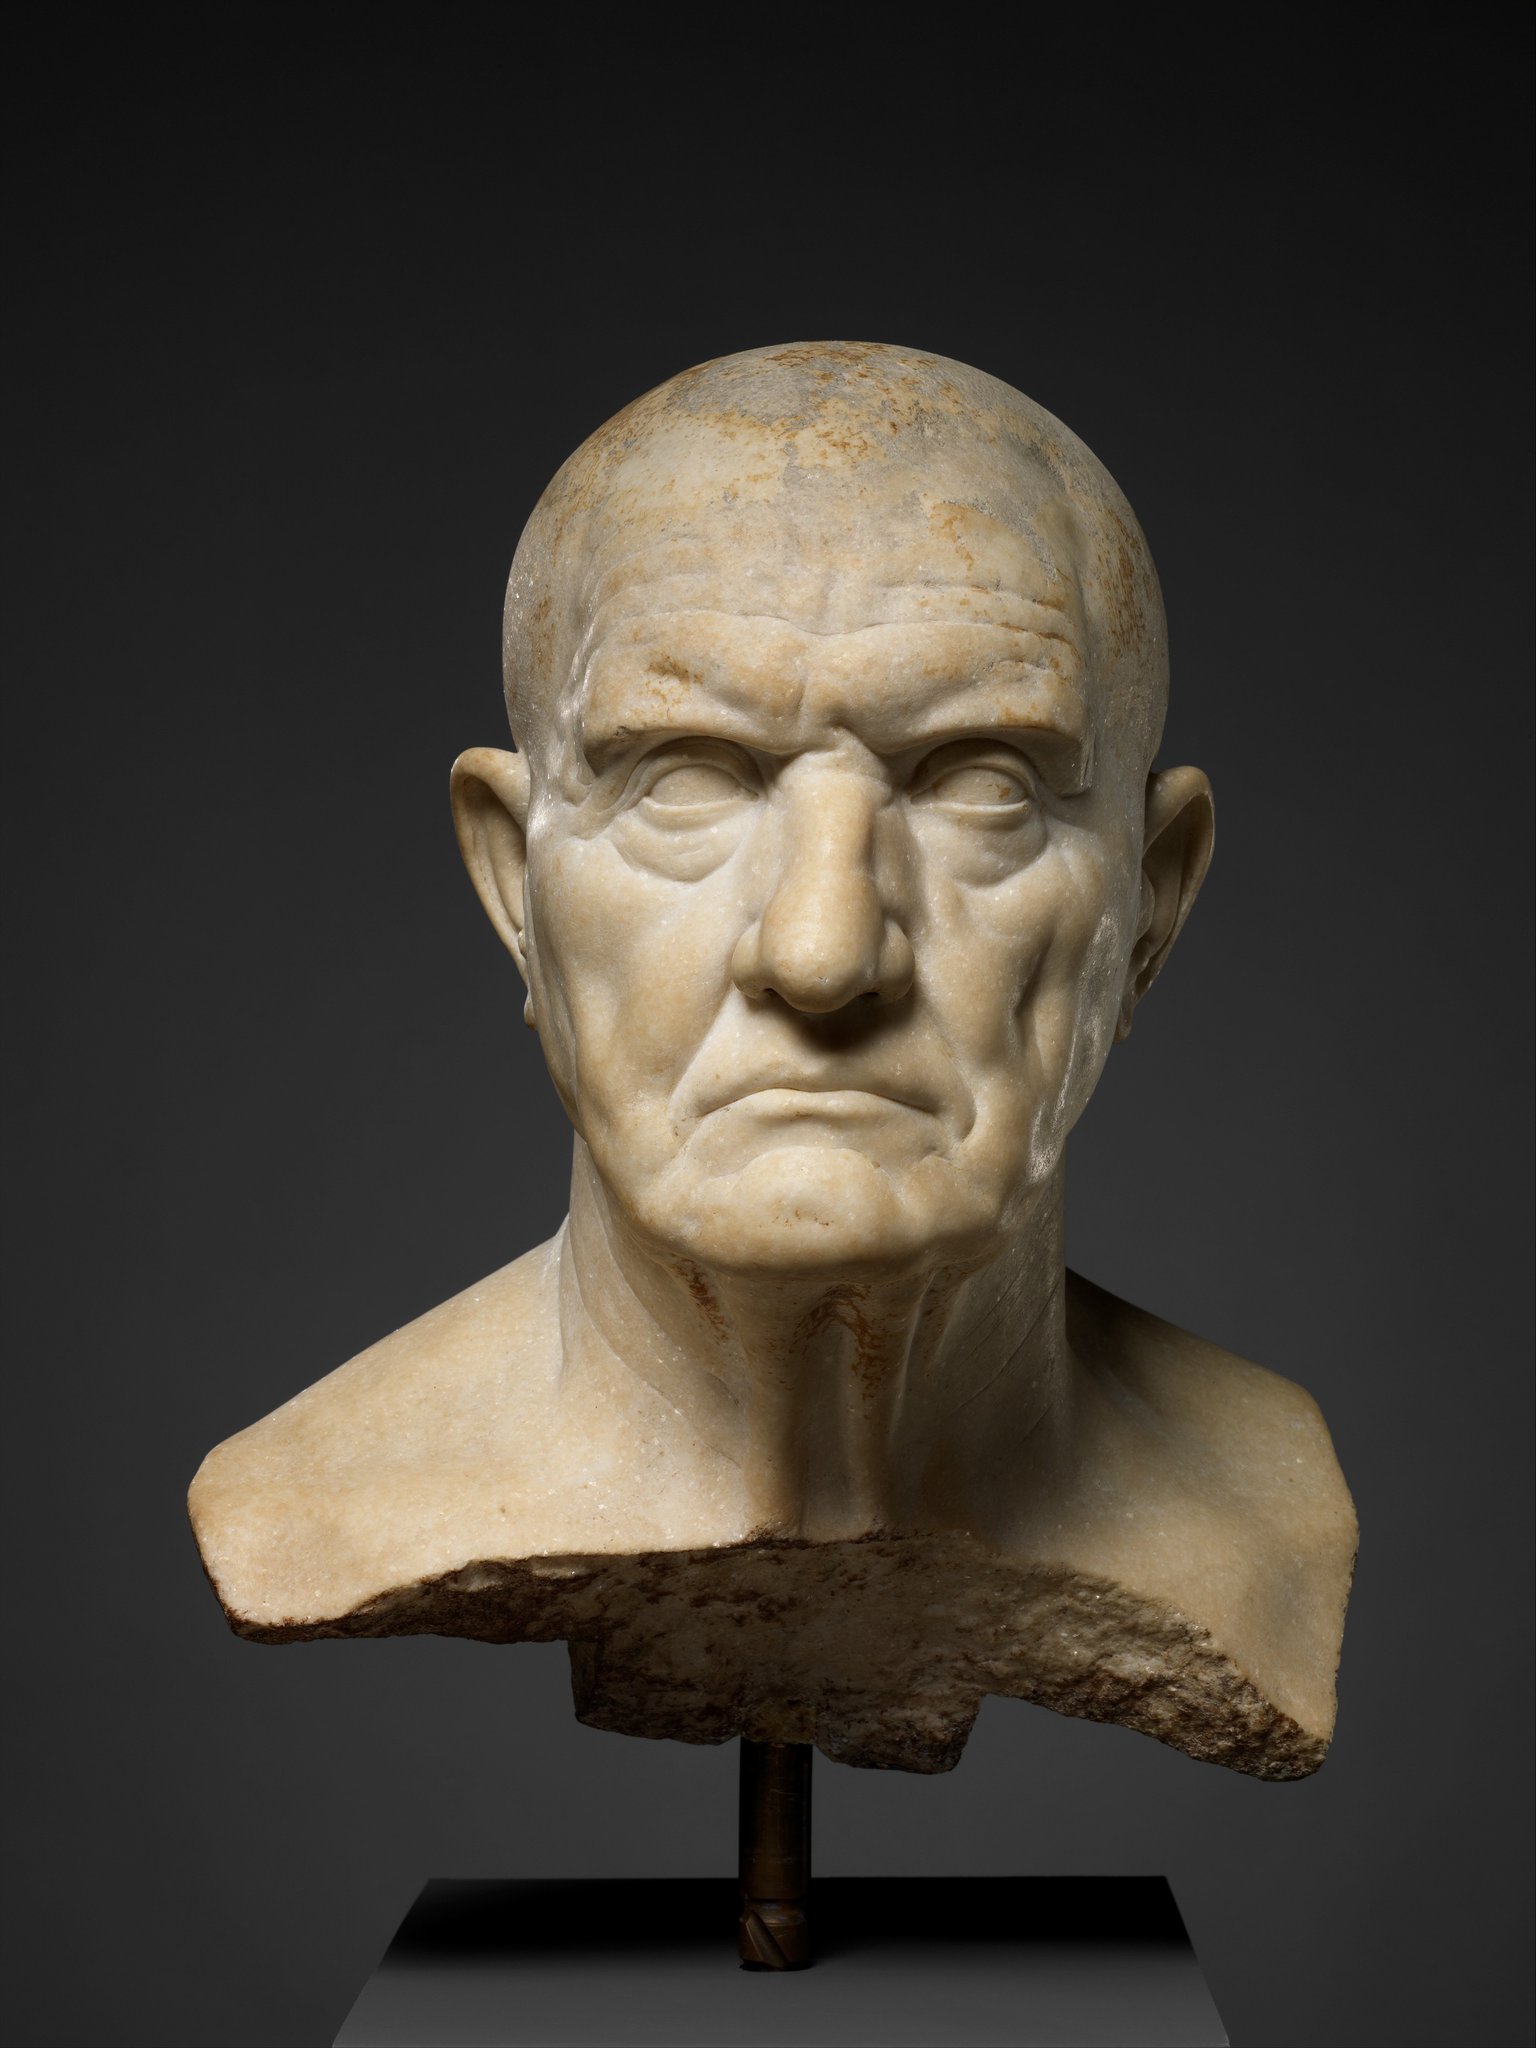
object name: portrait bust of a man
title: Marble bust of a man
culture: roman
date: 34-66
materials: marble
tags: men,portraits